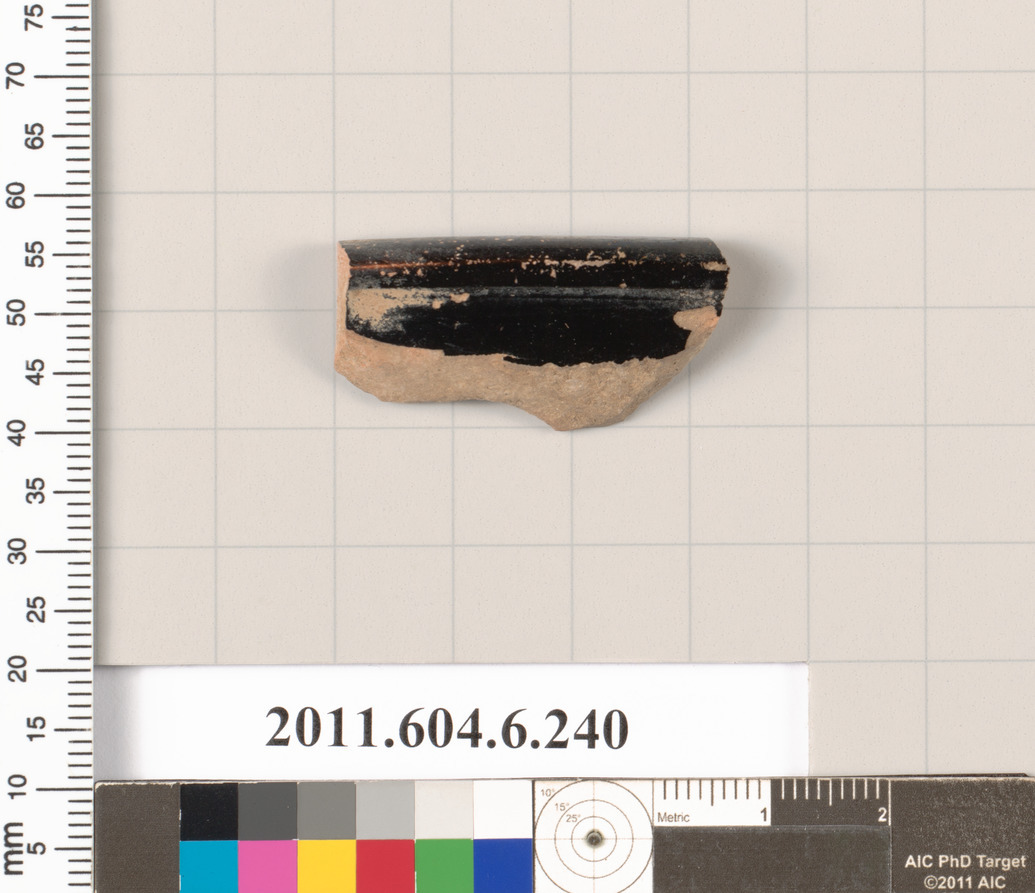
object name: fragment of a bowl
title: Terracotta fragment of a bowl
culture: greek, attic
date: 500-301 BCE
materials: terracotta